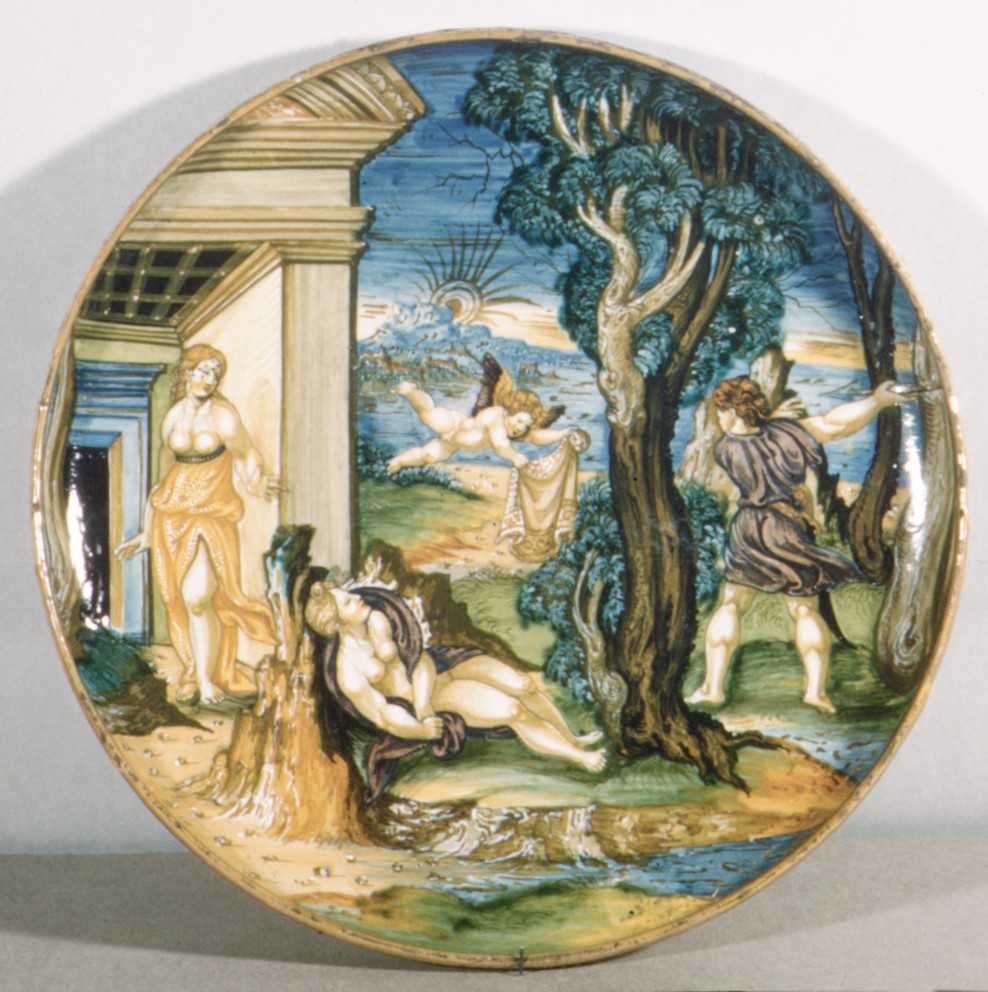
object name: tazza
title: Footed bowl depicting Cephalus killing Procris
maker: fra xanto avelli da rovigo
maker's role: artist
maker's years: 1486-1582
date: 1533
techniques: maiolica, glazing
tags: men,female nudes,putti